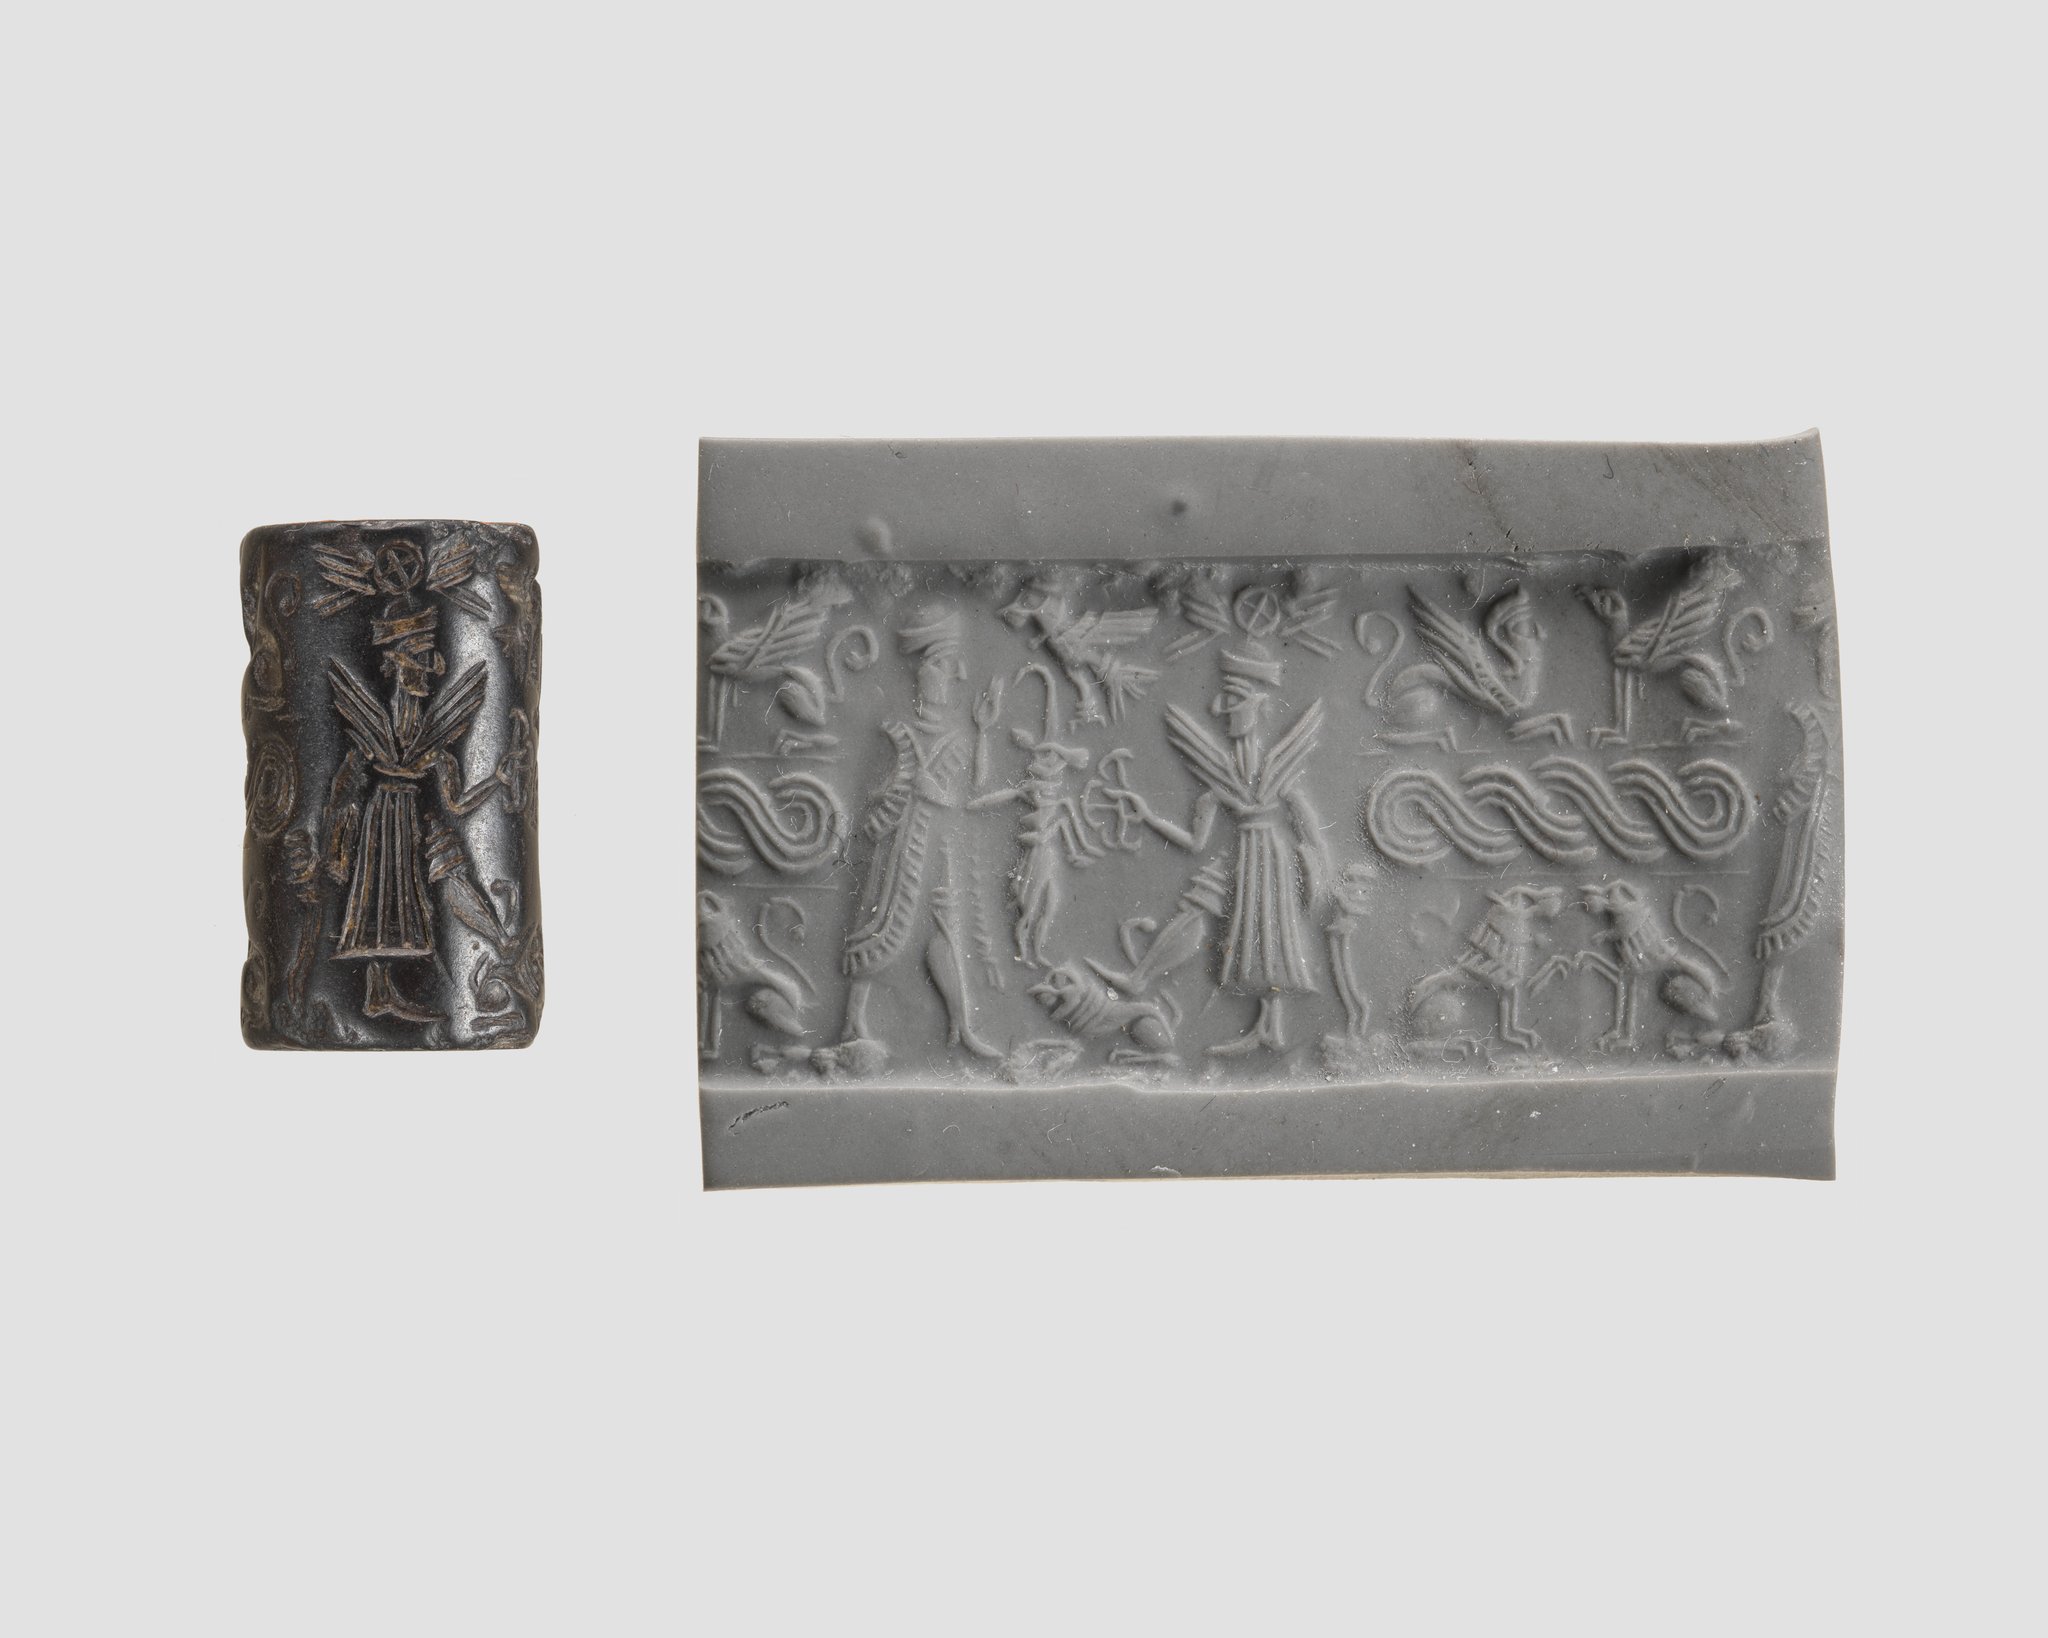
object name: cylinder seal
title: Cylinder seal and modern impression: offering bearer before winged deity; terminal: sphinxes, guilloche, lions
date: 1820-1730 BCE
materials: mineral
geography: syria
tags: sphinx,lions